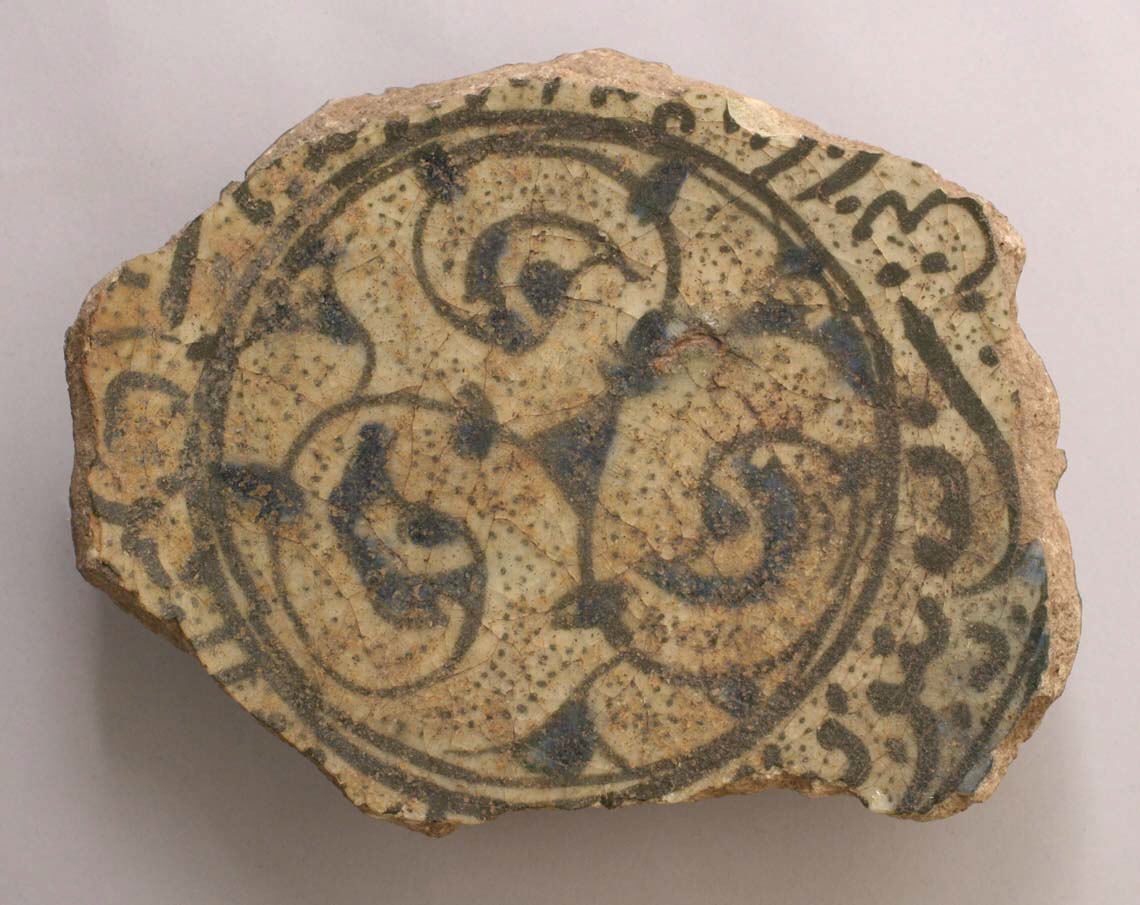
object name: fragment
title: Ceramic Fragment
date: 1301-1400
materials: glaze, stonepaste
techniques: painting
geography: syria